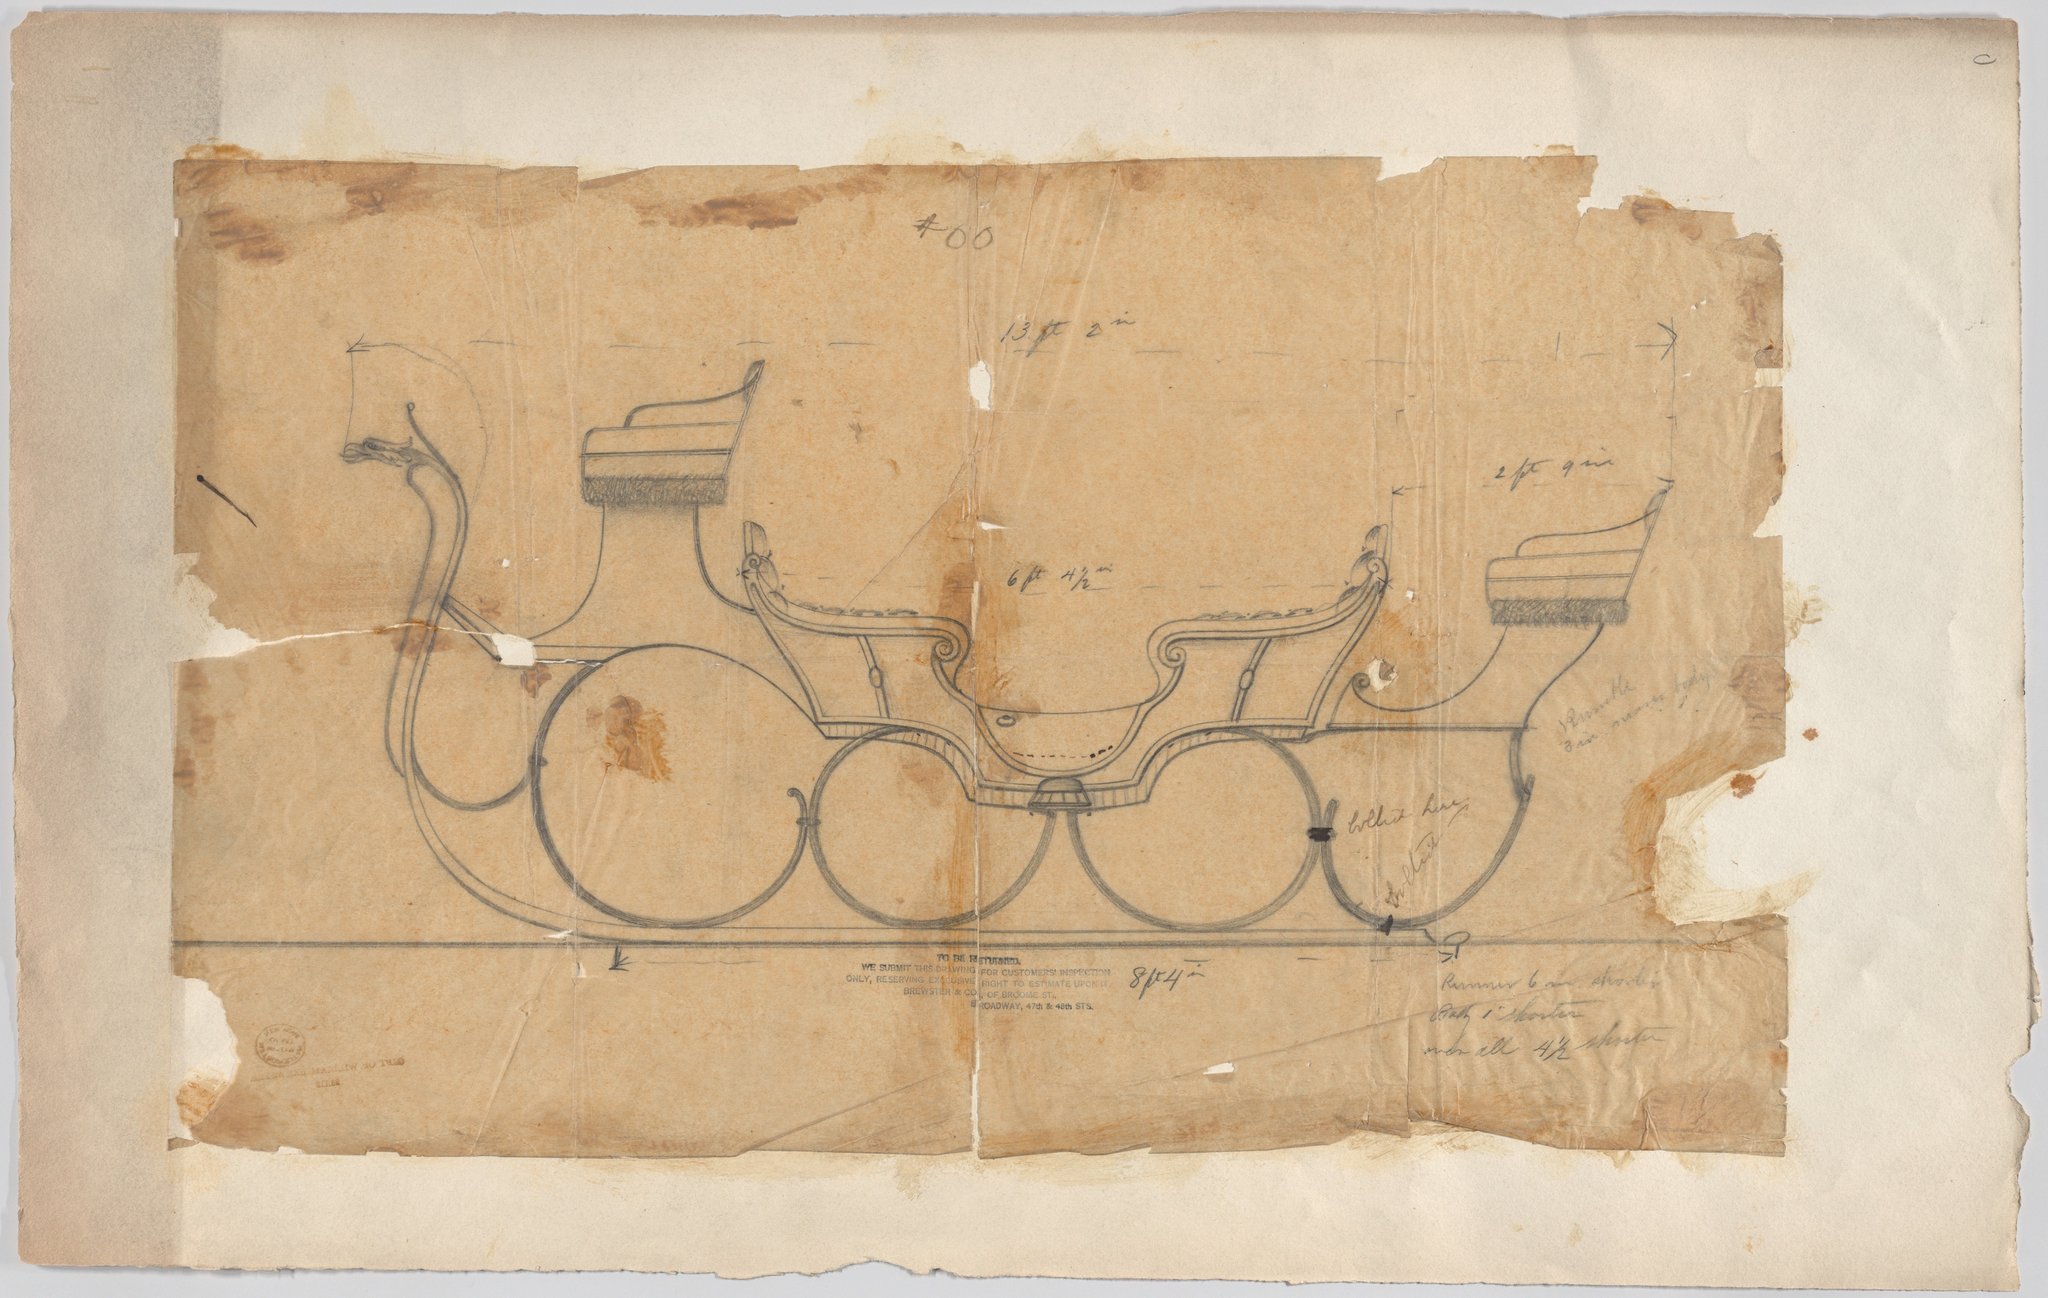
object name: drawing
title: Vis-a-Vis Sleigh #00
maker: brewster & co.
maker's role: manufacturer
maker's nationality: american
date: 1883-1884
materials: graphite, ink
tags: sleighs